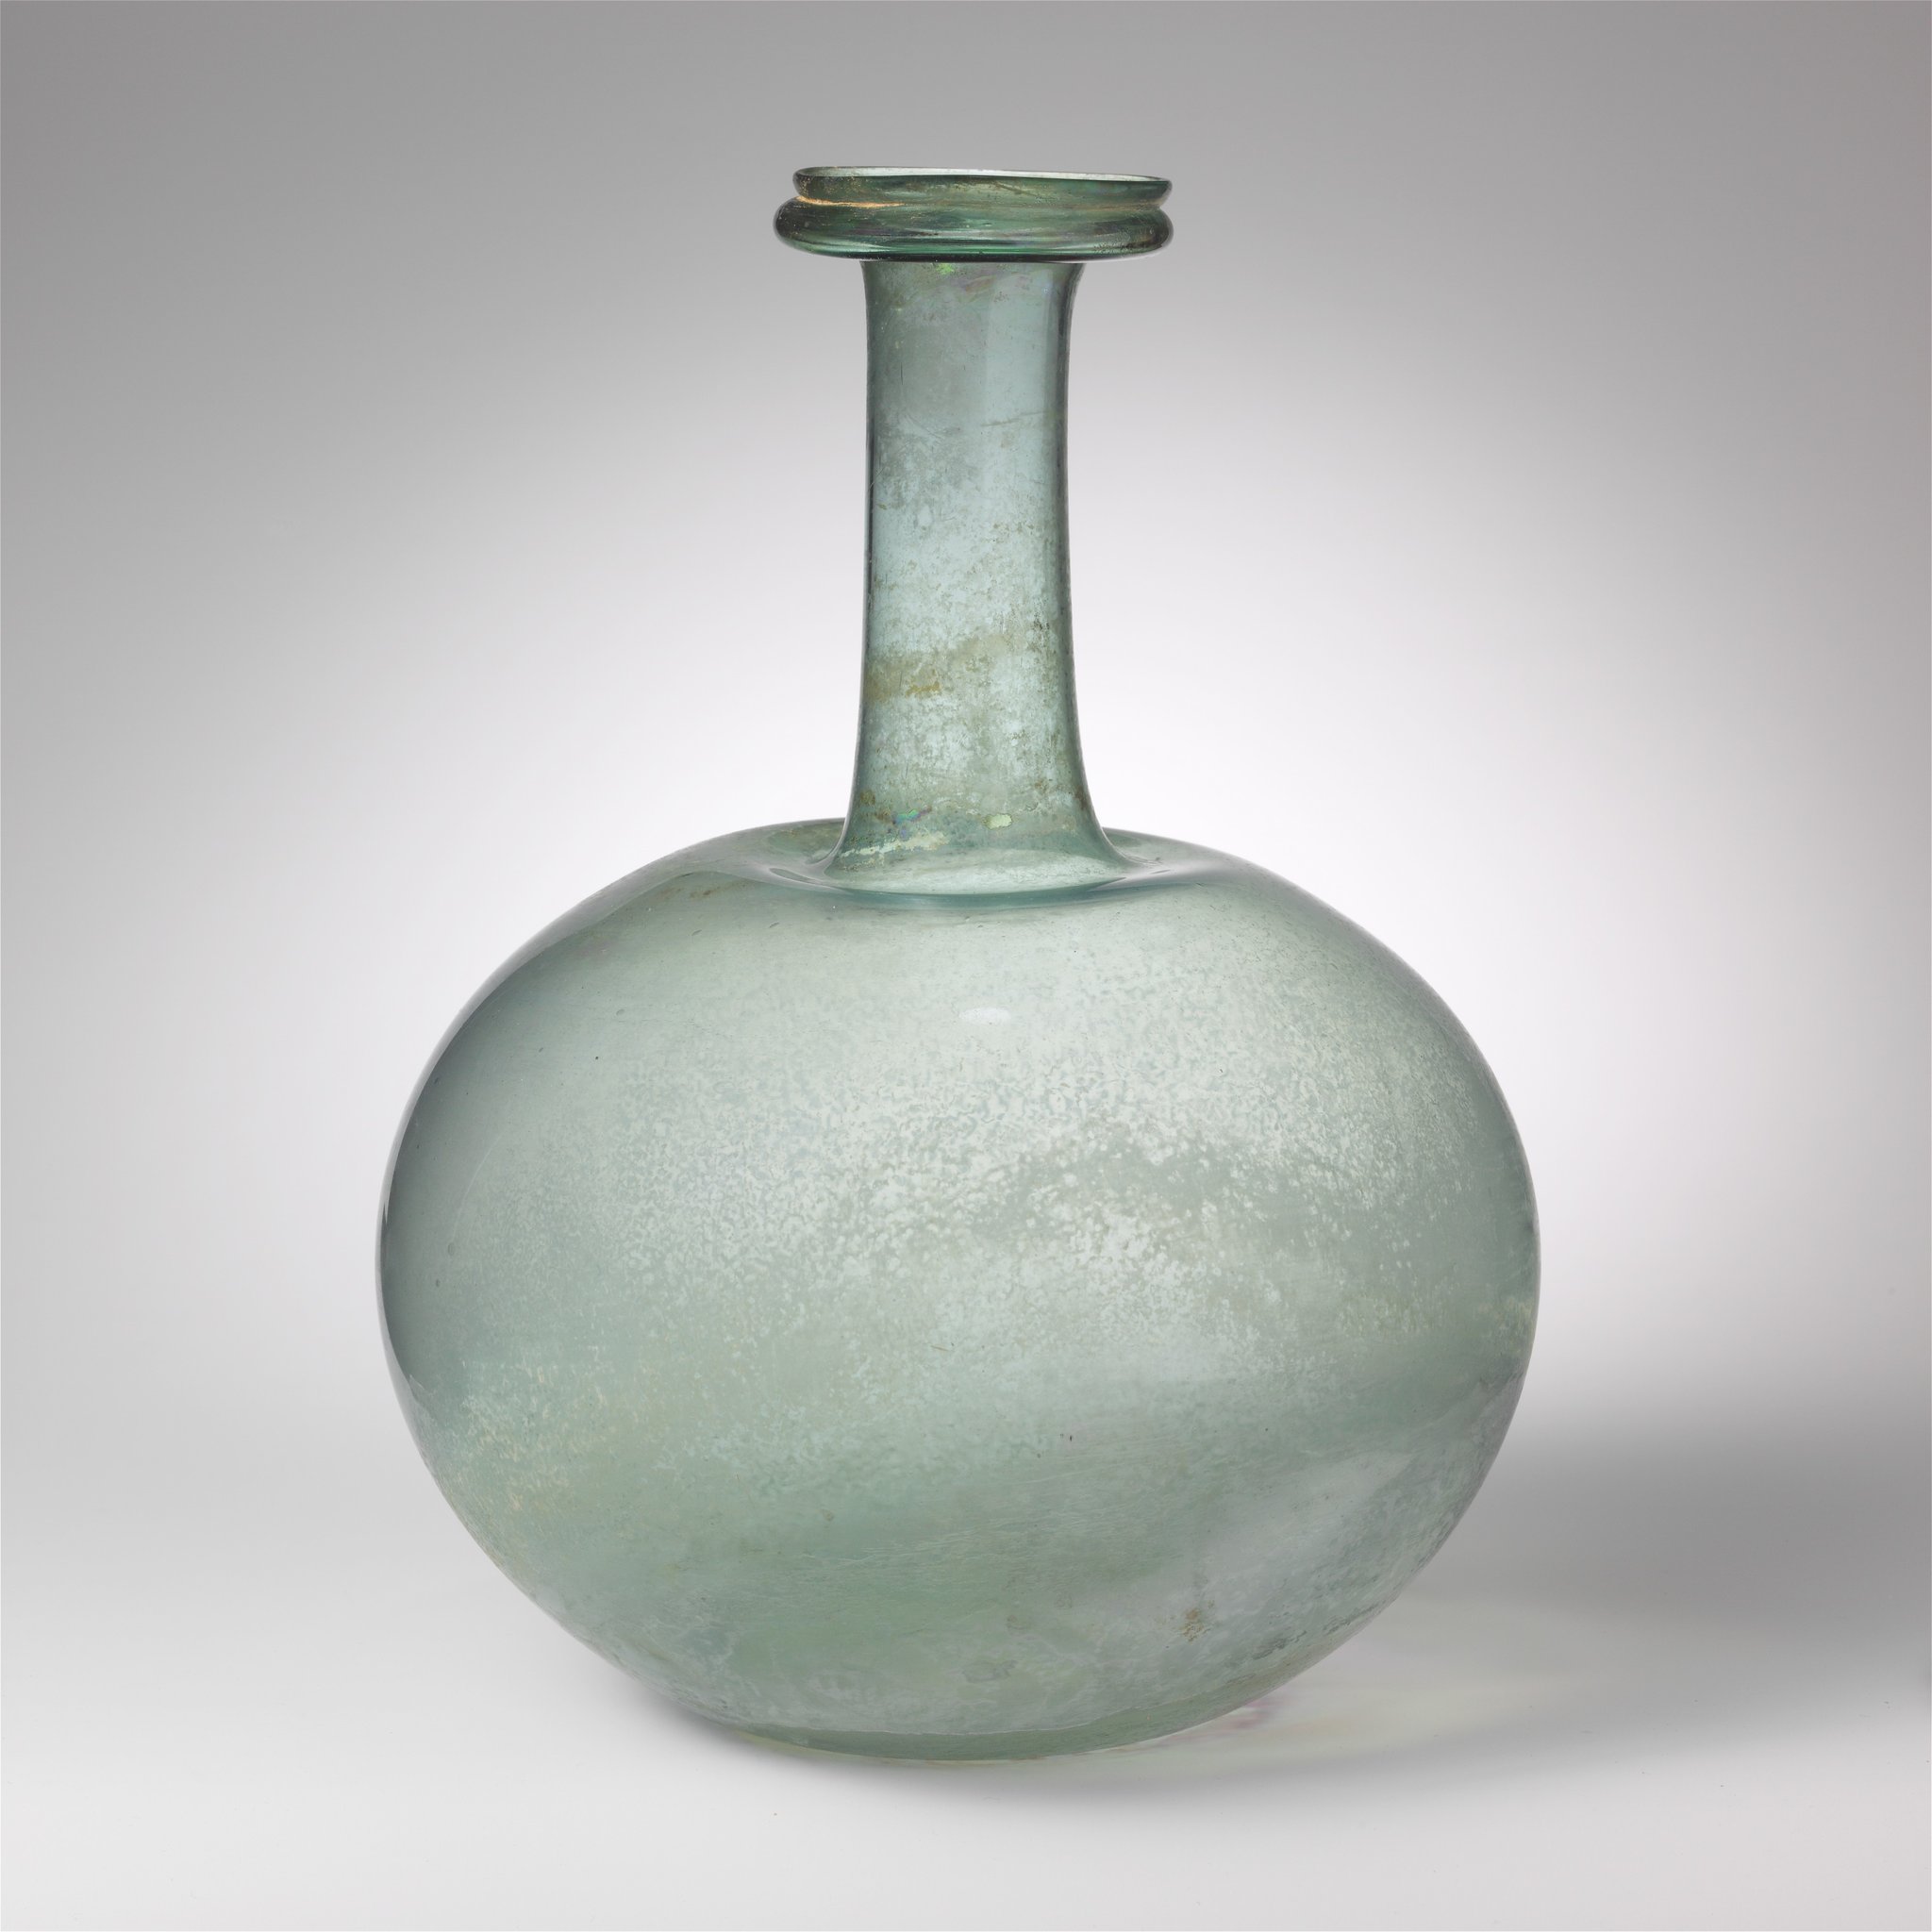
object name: bottle, globular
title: Glass globular bottle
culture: roman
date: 301-400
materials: glass